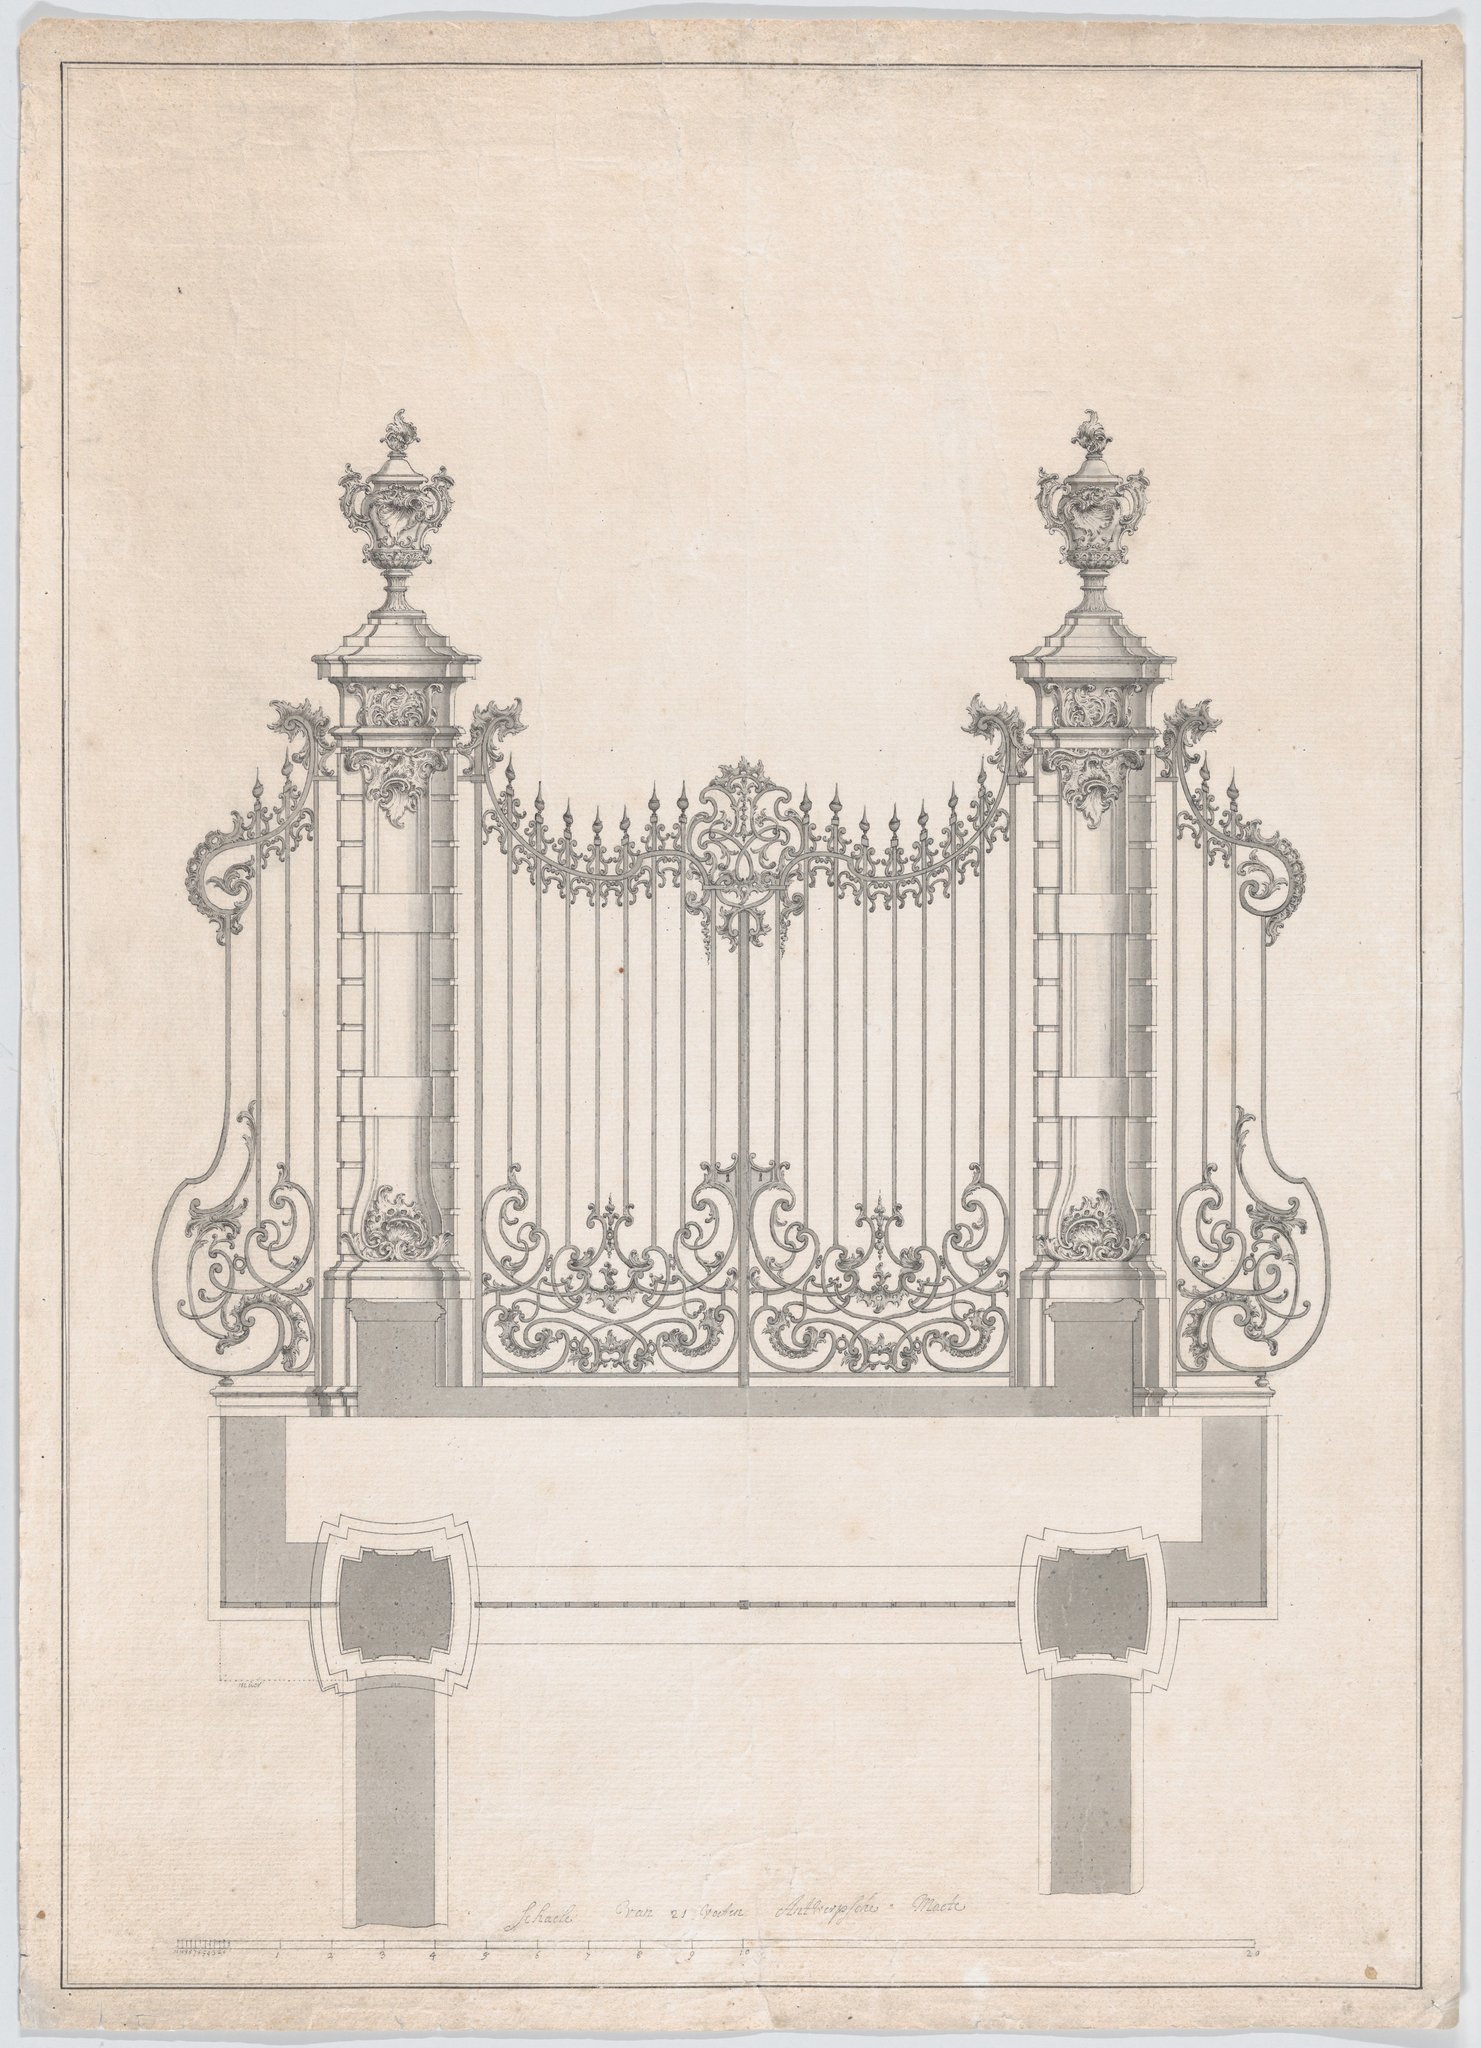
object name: drawing ornament architecture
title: Design for the Cast Iron Gate of Castle ‘s-Gravenwezel (Belgium)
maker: jan pieter van baurscheidt the younger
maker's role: artist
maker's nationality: flemish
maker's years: 1699-1768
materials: ink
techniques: pen, wash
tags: gates